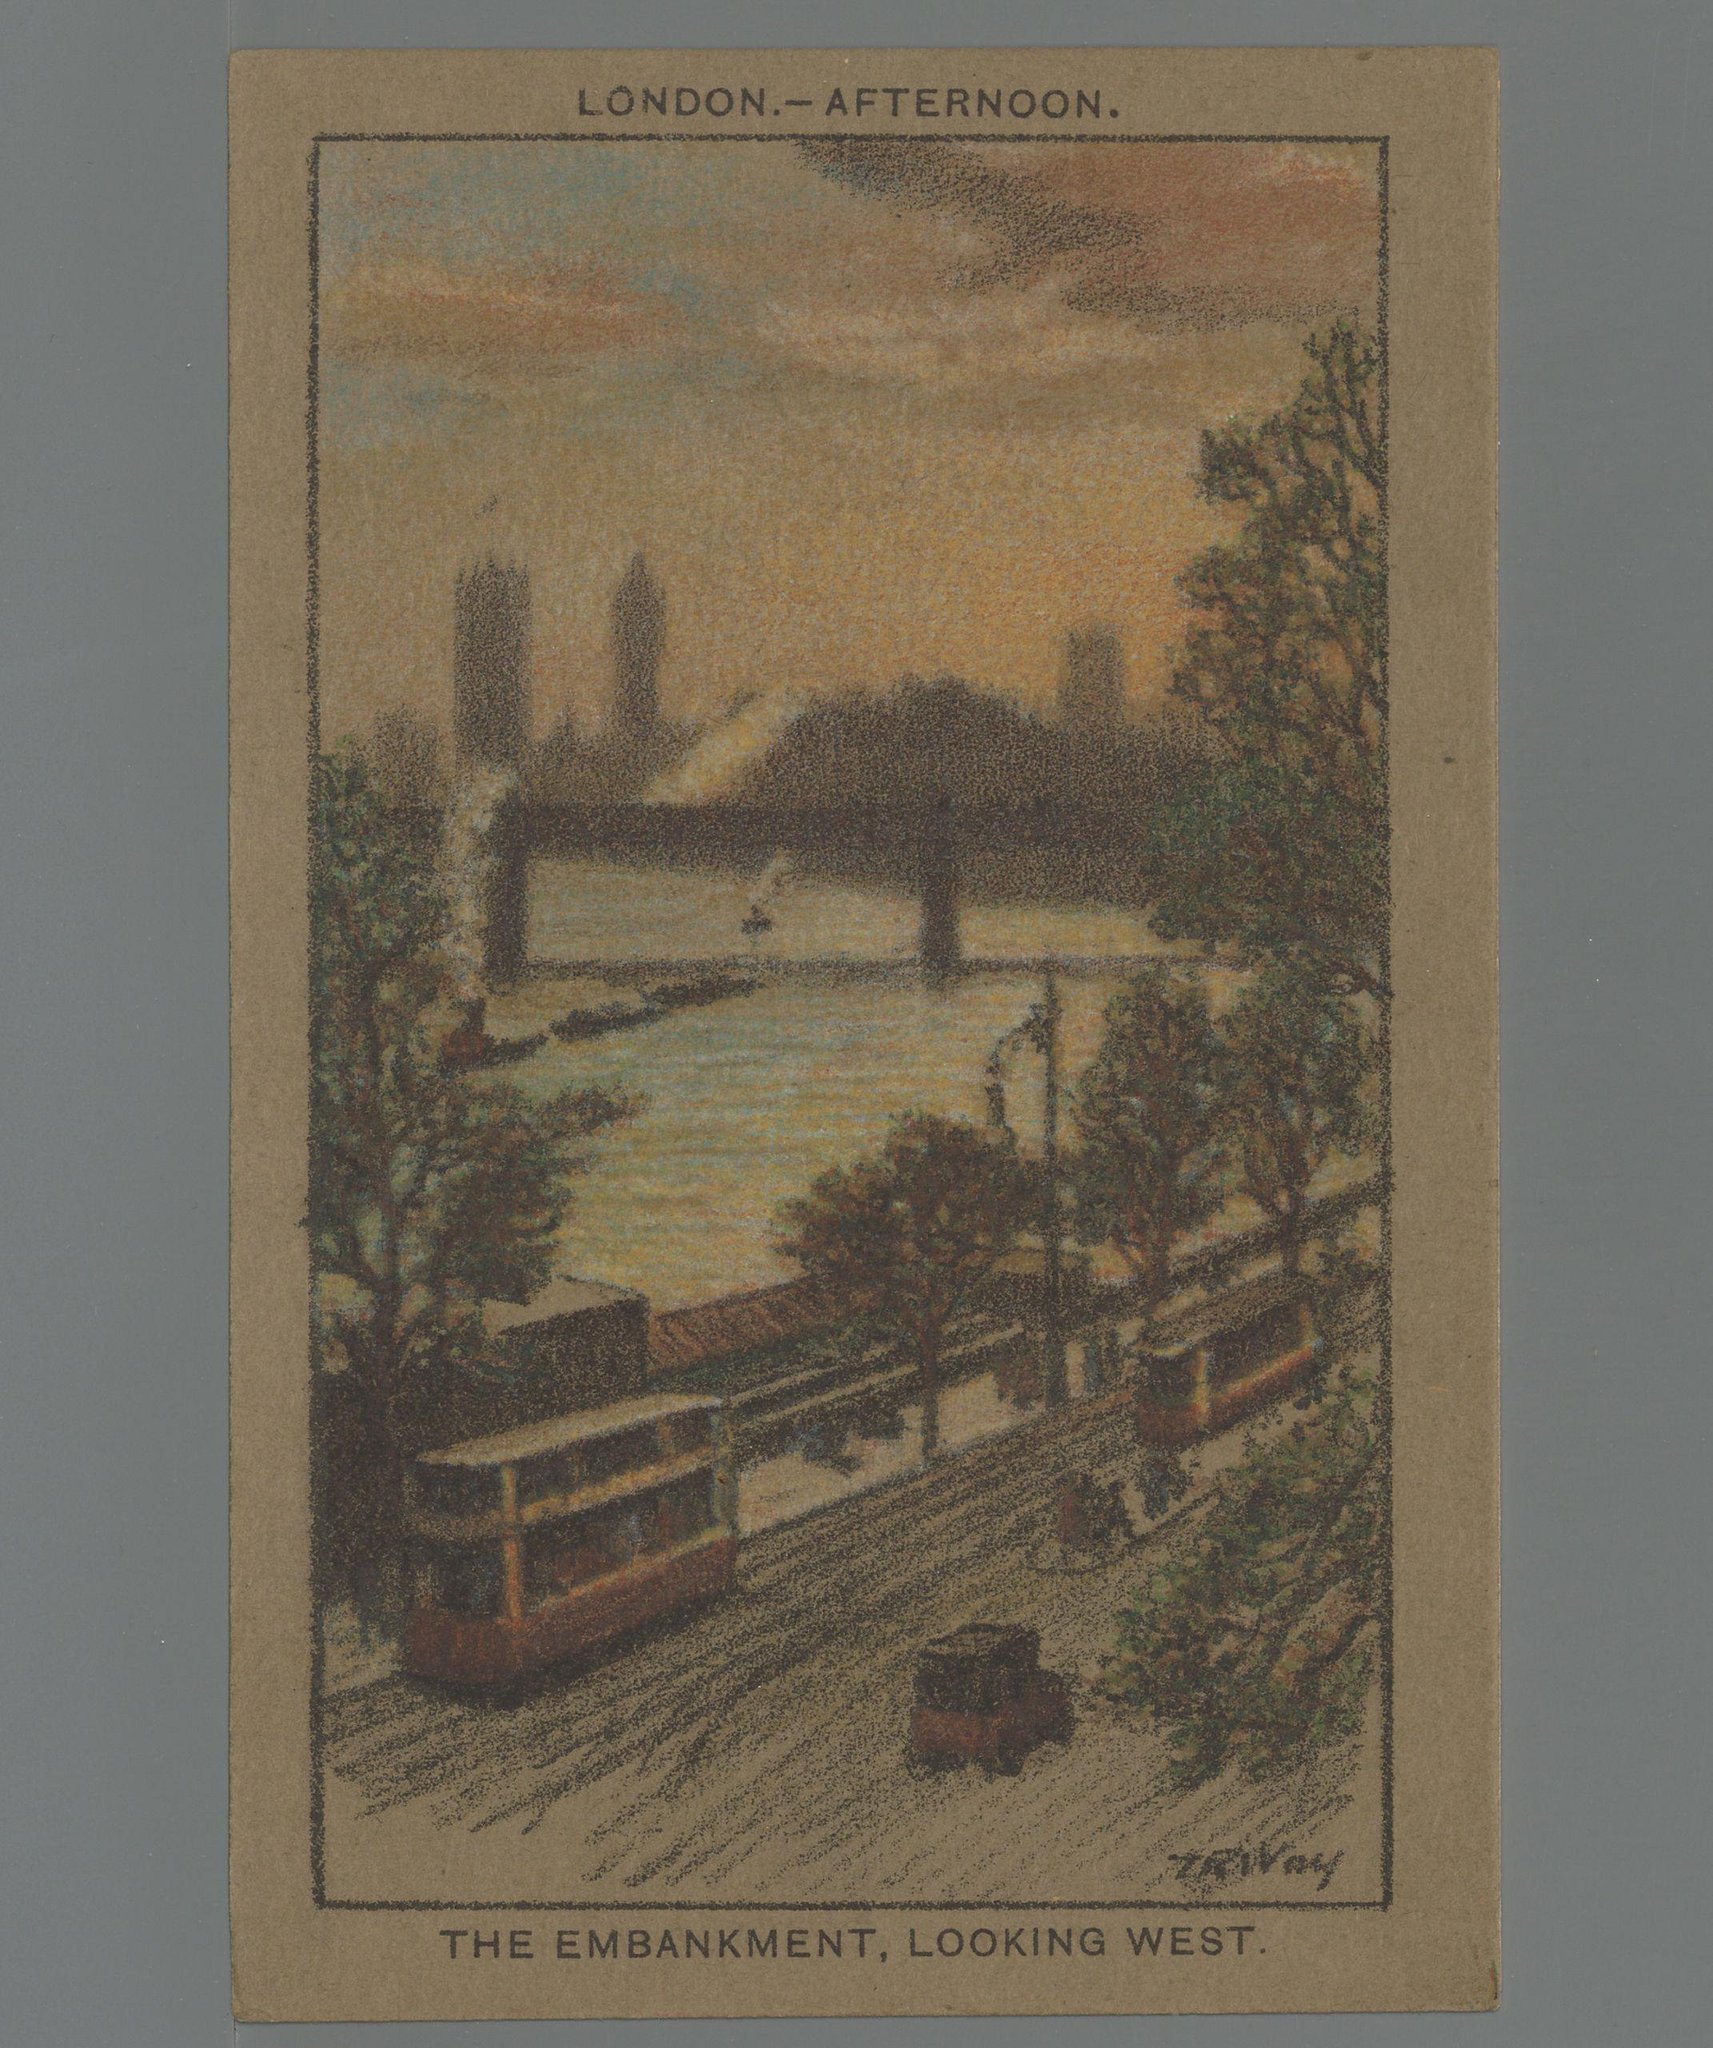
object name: ansichtkaart, prentbriefkaart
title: London.- Afternoon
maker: thomas robert way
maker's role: print maker, printer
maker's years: 1861-1913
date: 1902-1913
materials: cardboard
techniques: lithograph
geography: london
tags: canals, waters (in city), bridge in city across river, canal, etc., quay, thames